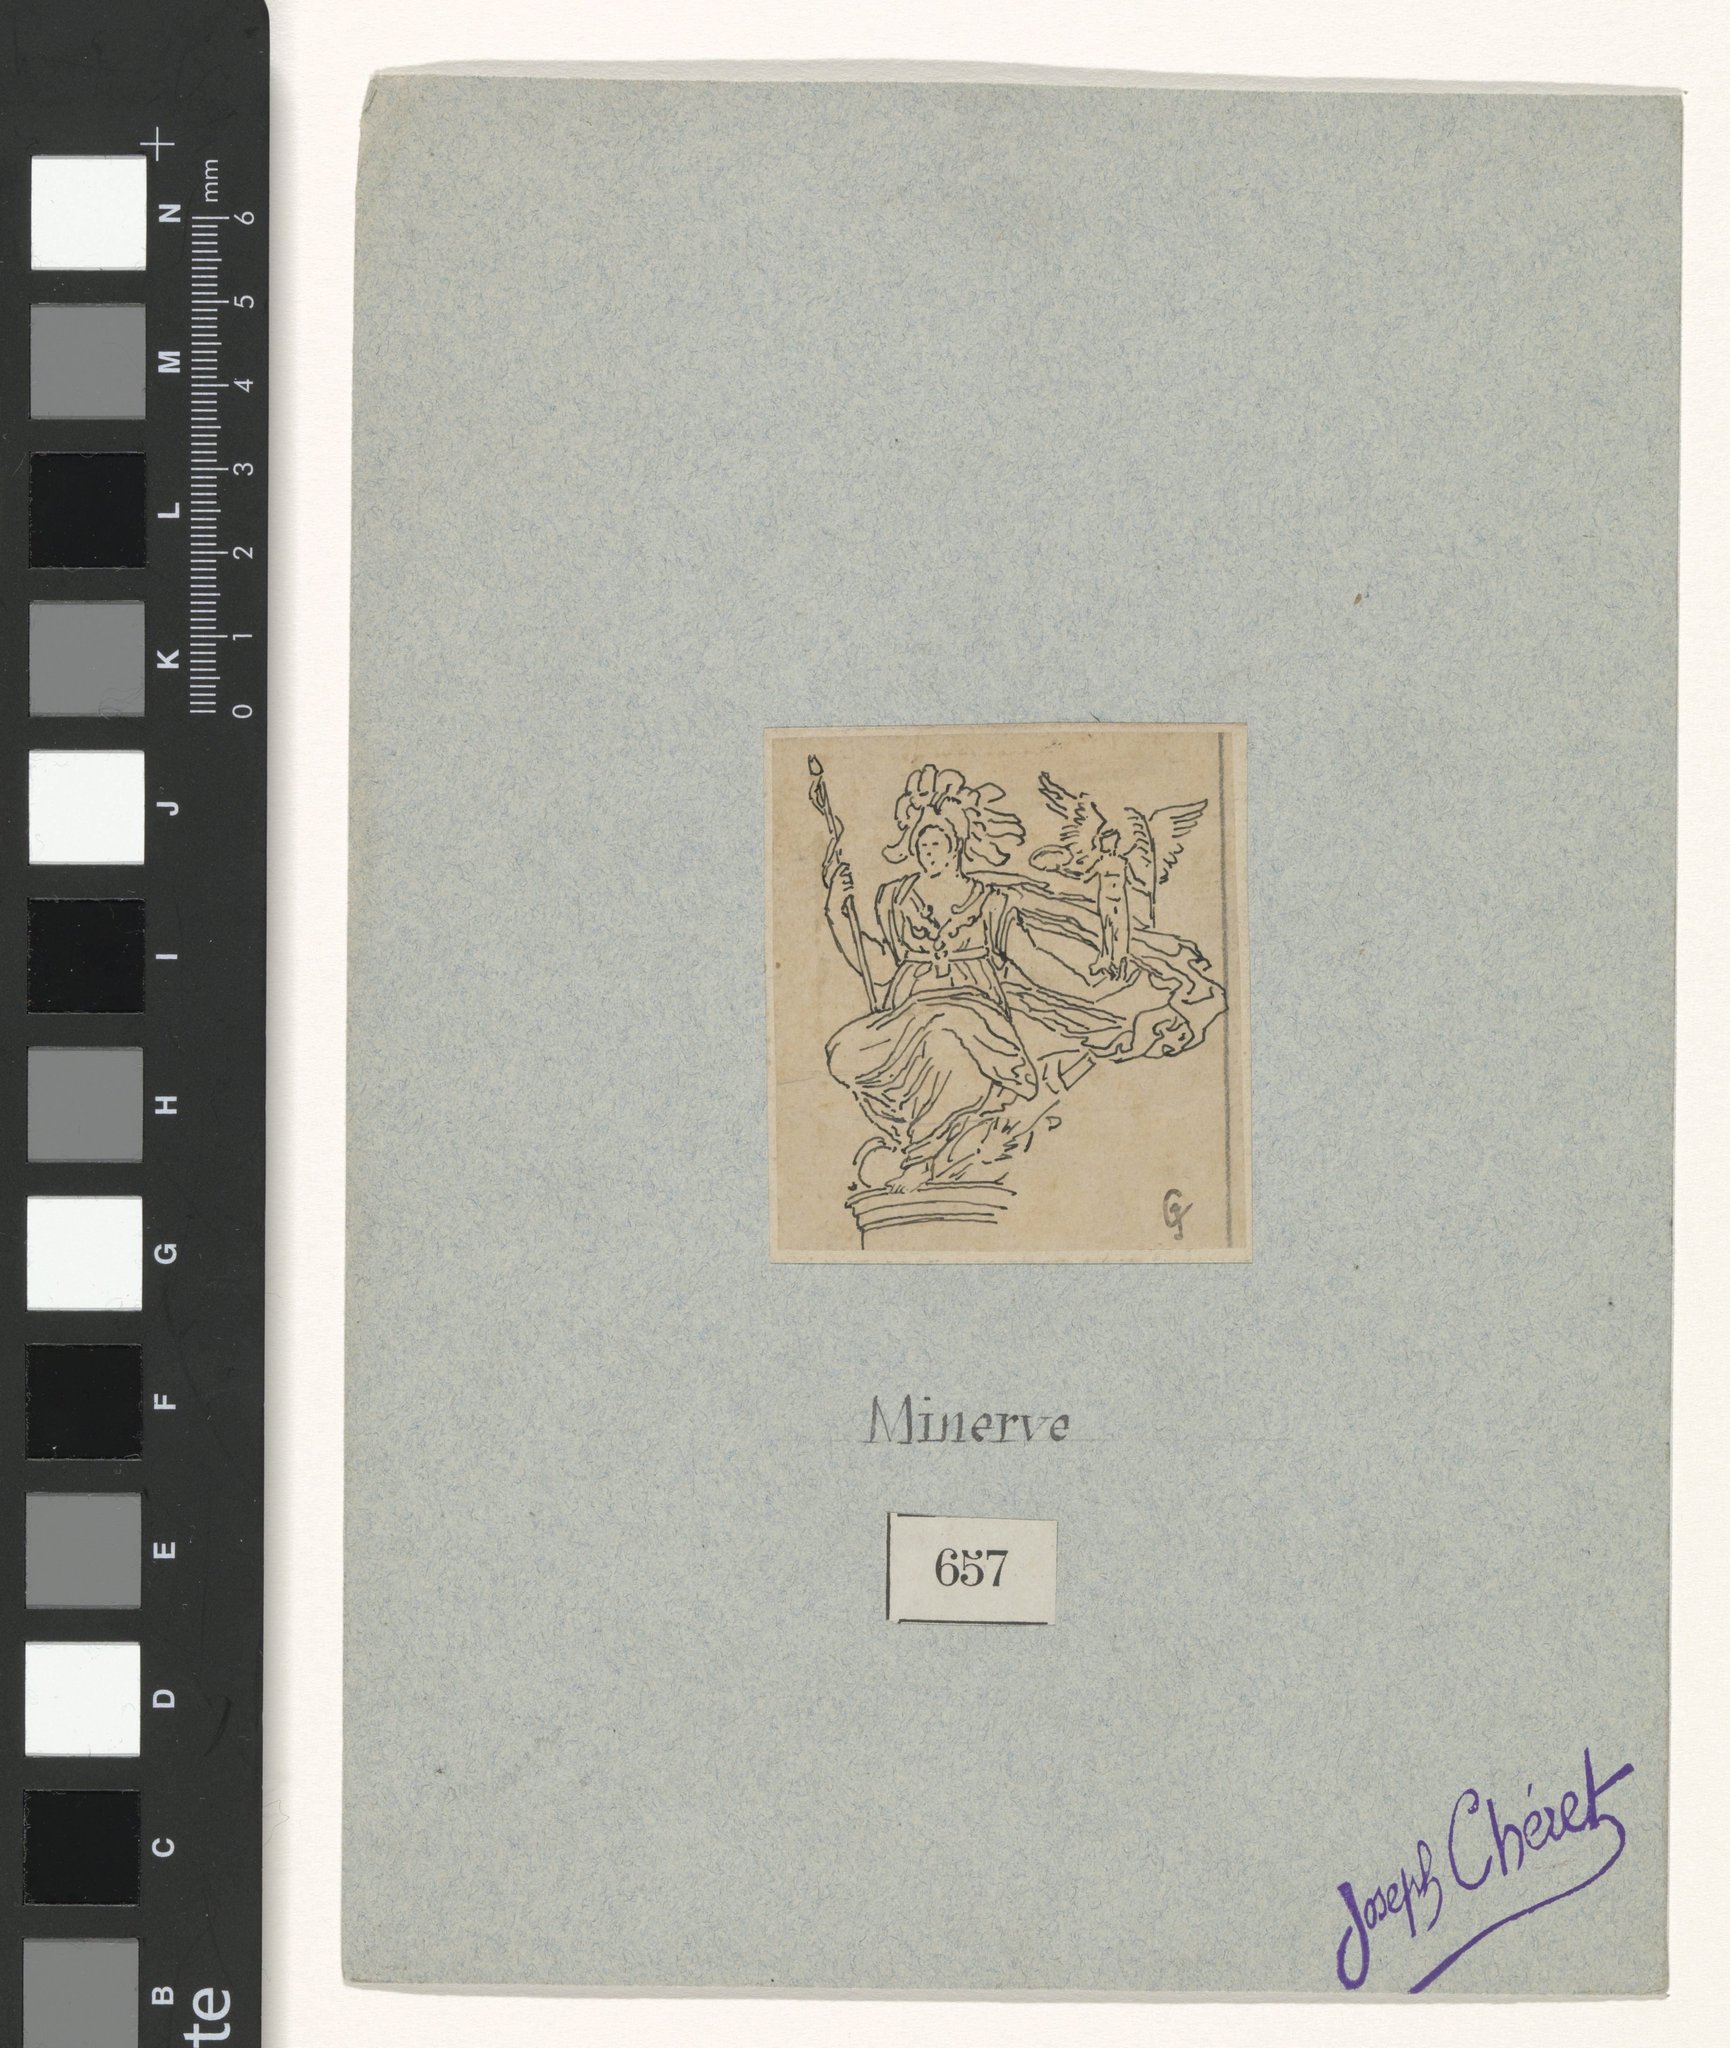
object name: design drawing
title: Minerva met figuur van Nike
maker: gustave joseph chéret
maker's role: sculptor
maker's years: 1838-1894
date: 1870-1894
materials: cardboard, ink, paper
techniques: pen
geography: paris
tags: (story of) minerva (pallas, athena)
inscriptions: workshop stamp: ‘Joseph Chéret’, monogram: ‘JC’, inscription: ‘Minerve’, label: ‘657’